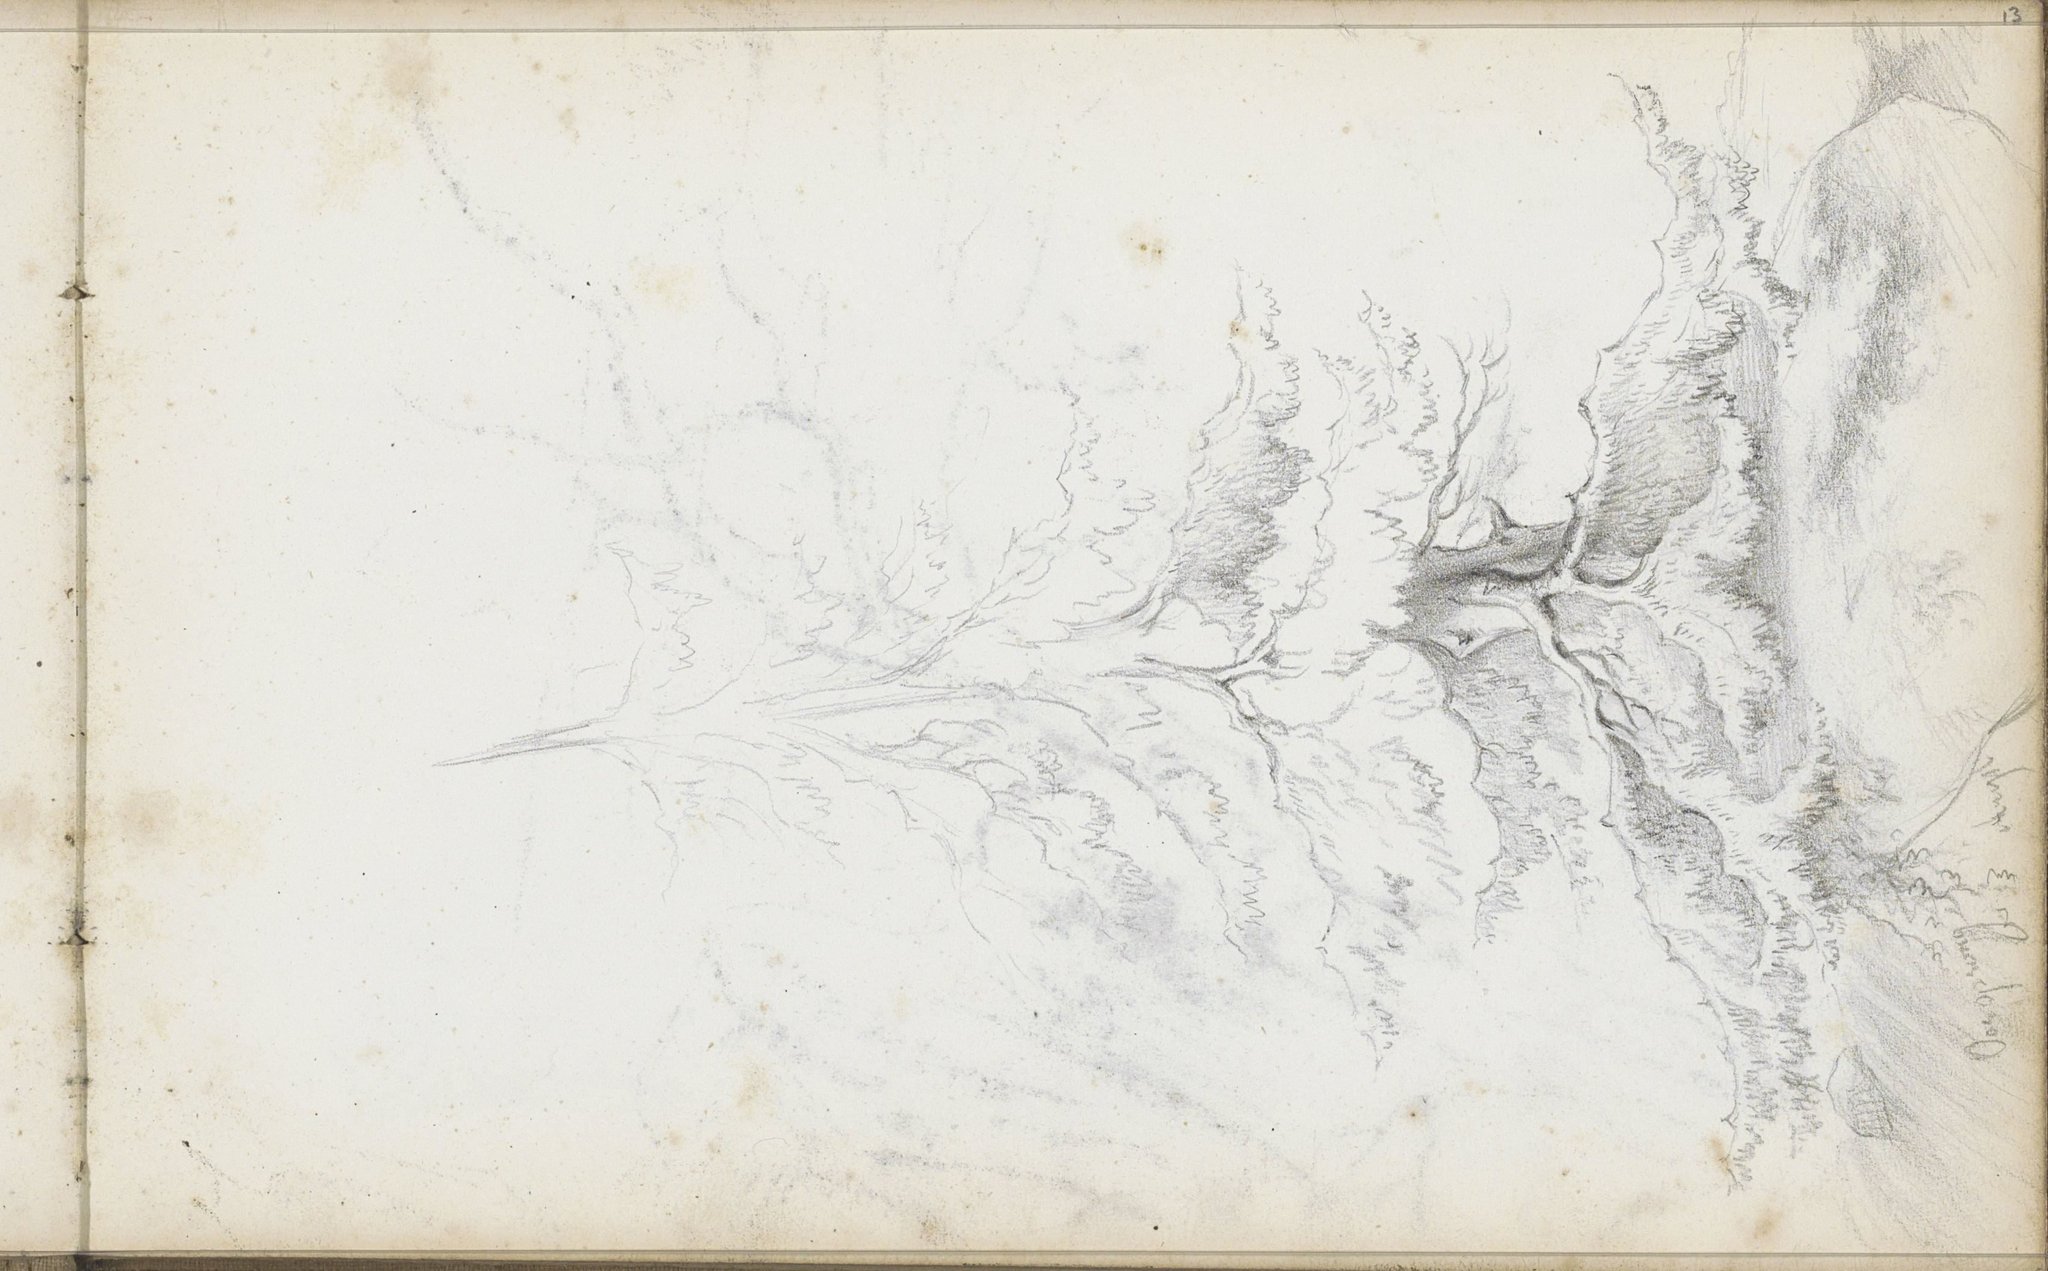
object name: sketchbook leaf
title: Boom op landgoed Oorsprong te Oosterbeek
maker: willem cornelis rip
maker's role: draughtsman, painter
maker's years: 1856-1922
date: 1808-1874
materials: paper, pencil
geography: de oorsprong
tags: trees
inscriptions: date and inscription: ‘Oorsprong/ Augst’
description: Blad 13 recto uit een schetsboek met 47 bladen.